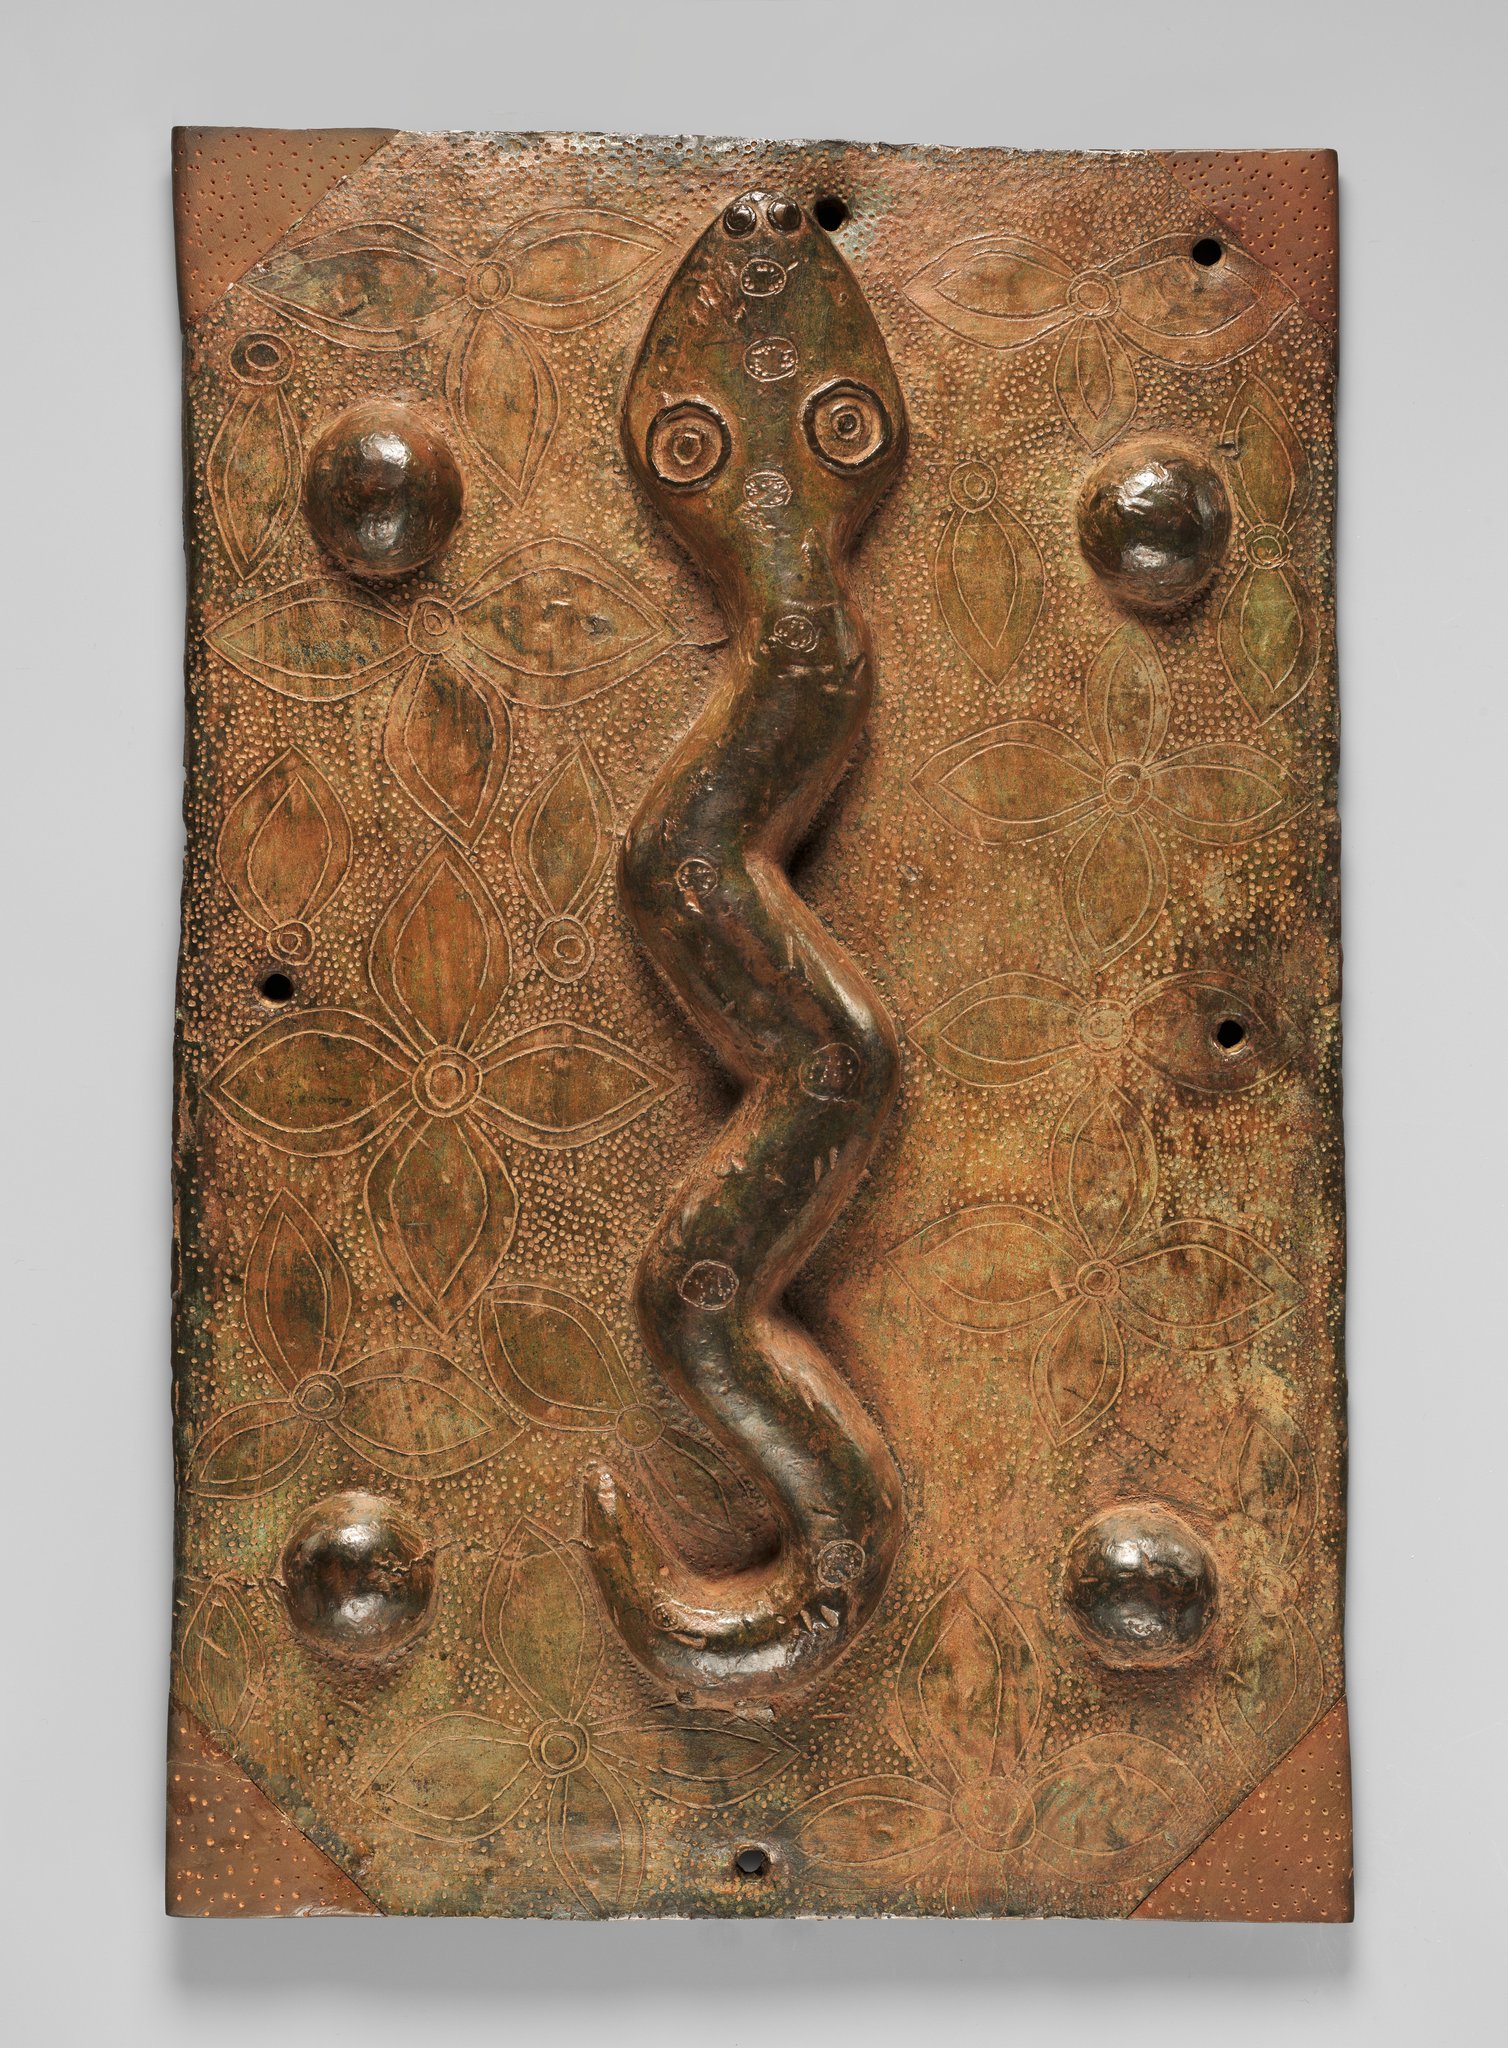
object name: plaque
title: Plaque: Snake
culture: edo period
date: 1501-1700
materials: bronze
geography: nigeria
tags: snakes